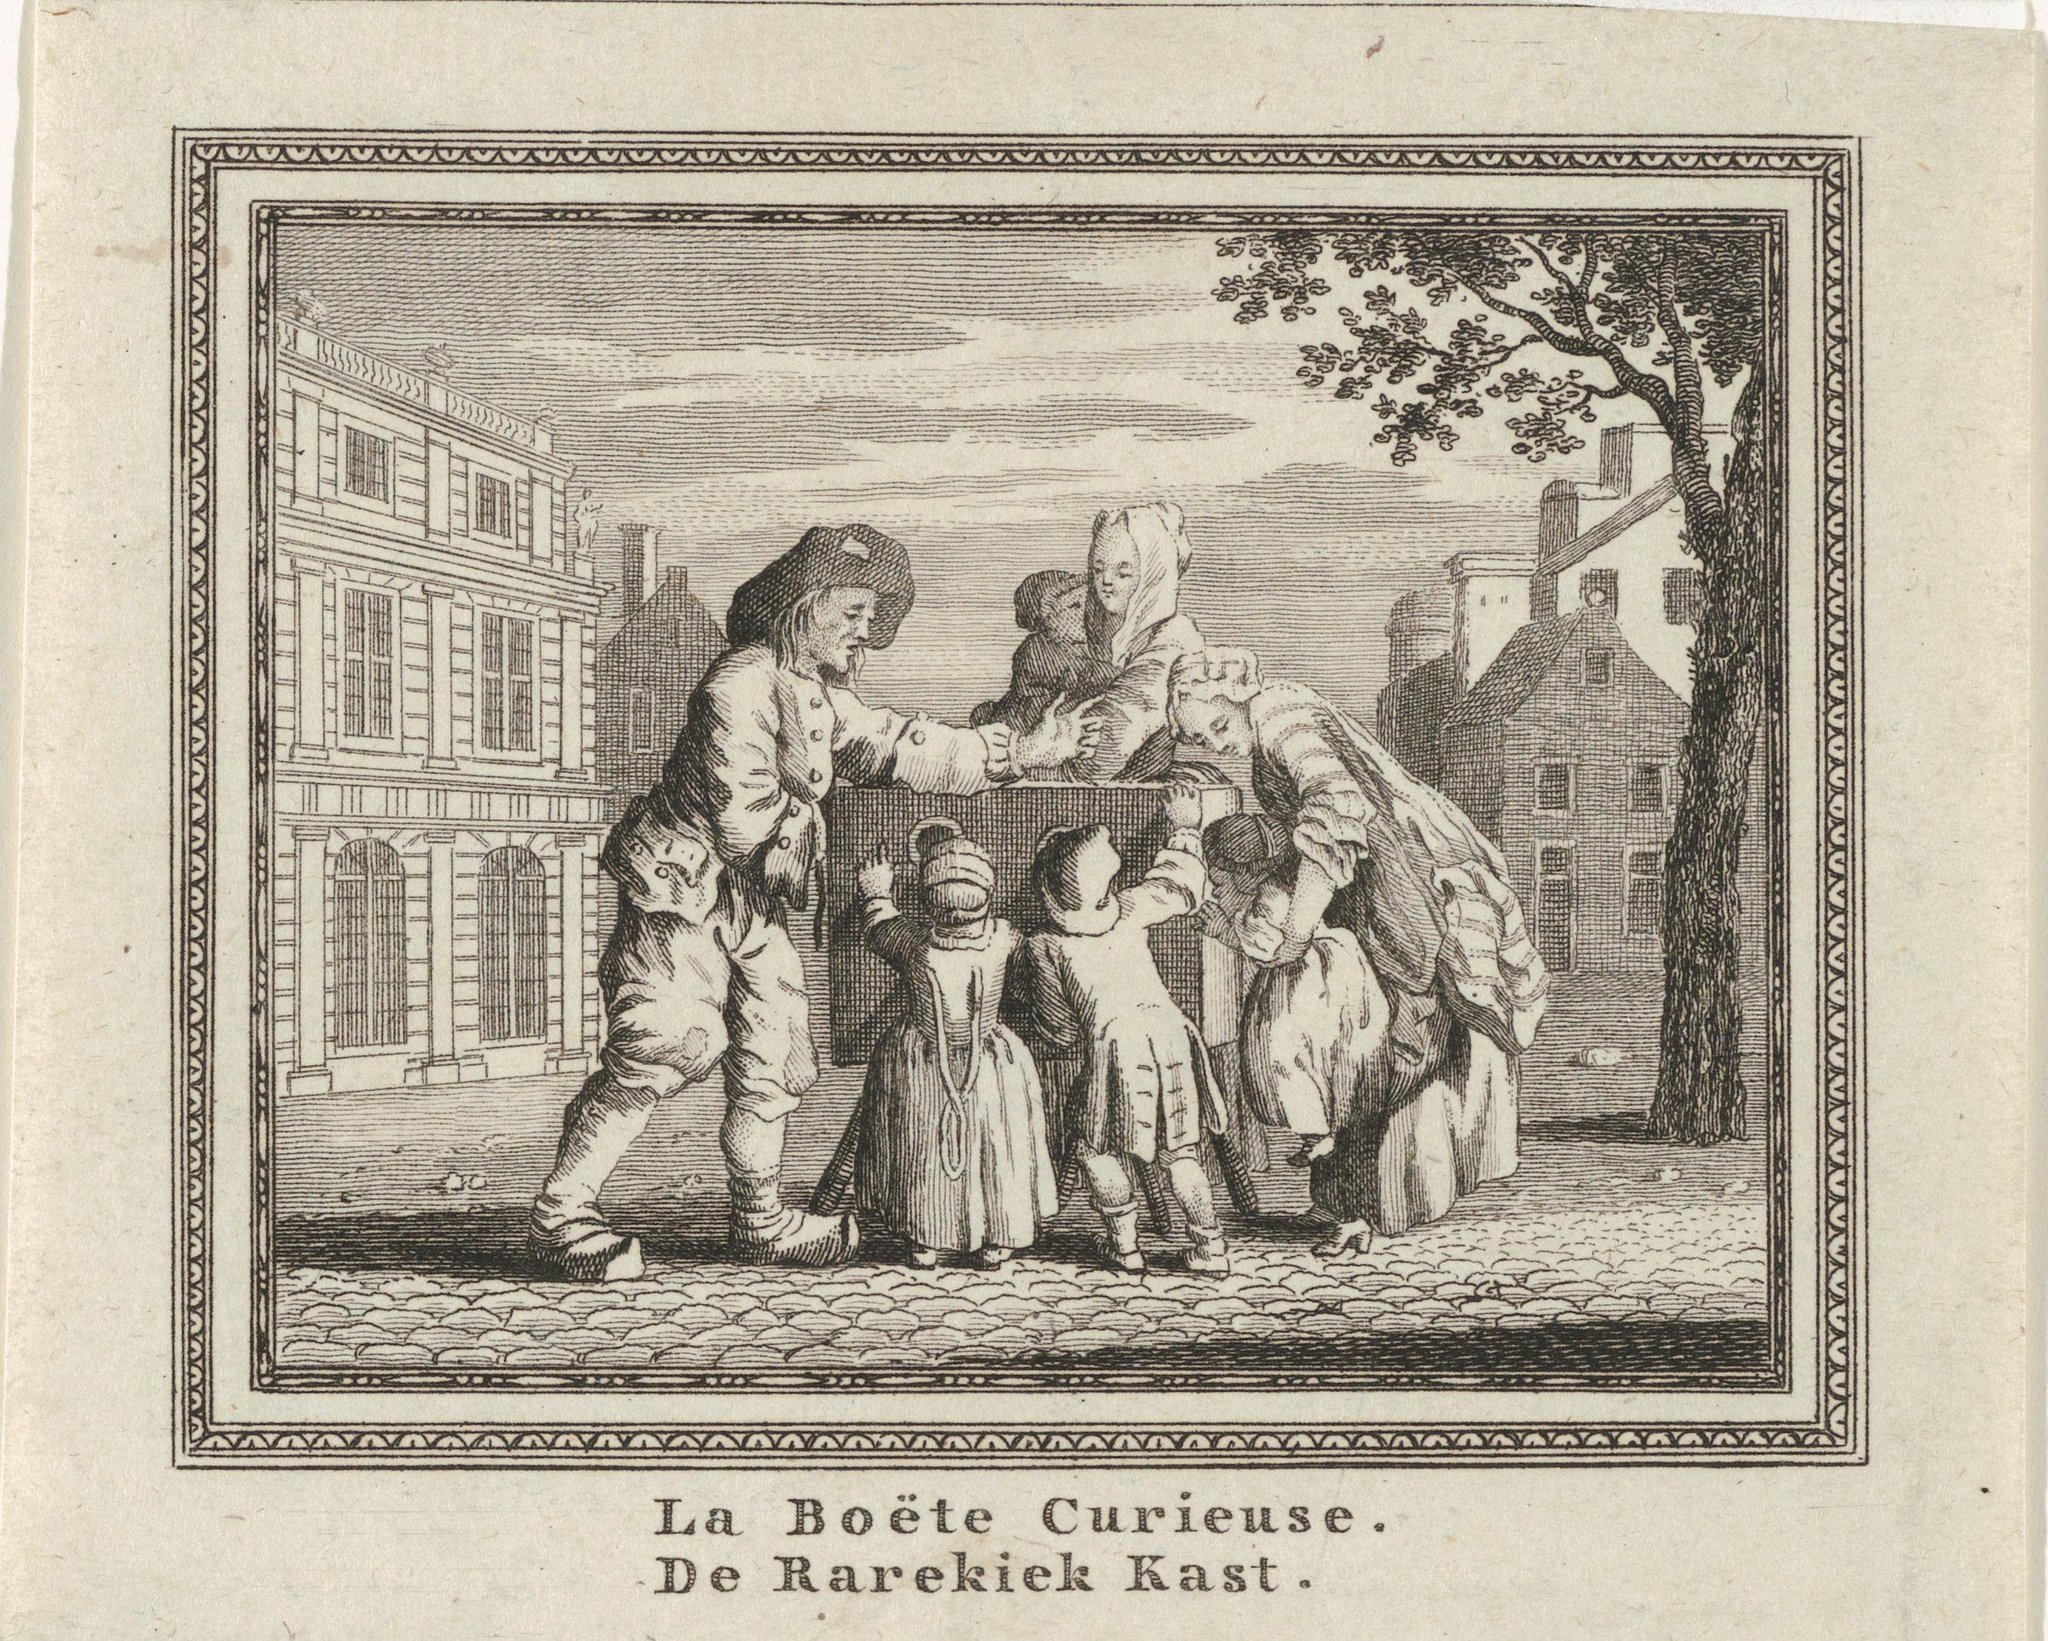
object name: print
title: La boëte curieuse / De rarekiek kast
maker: Anonymous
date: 1750-1850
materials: paper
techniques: etching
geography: netherlands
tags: child and art, 'fahrende leute', vagrants, peep-show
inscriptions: collector's mark: Lugt 2228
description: Een man presenteert op een plein een kijkkast aan een groepje kinderen en hun moeders. In de rarekiek zijn scènes voorgesteld.